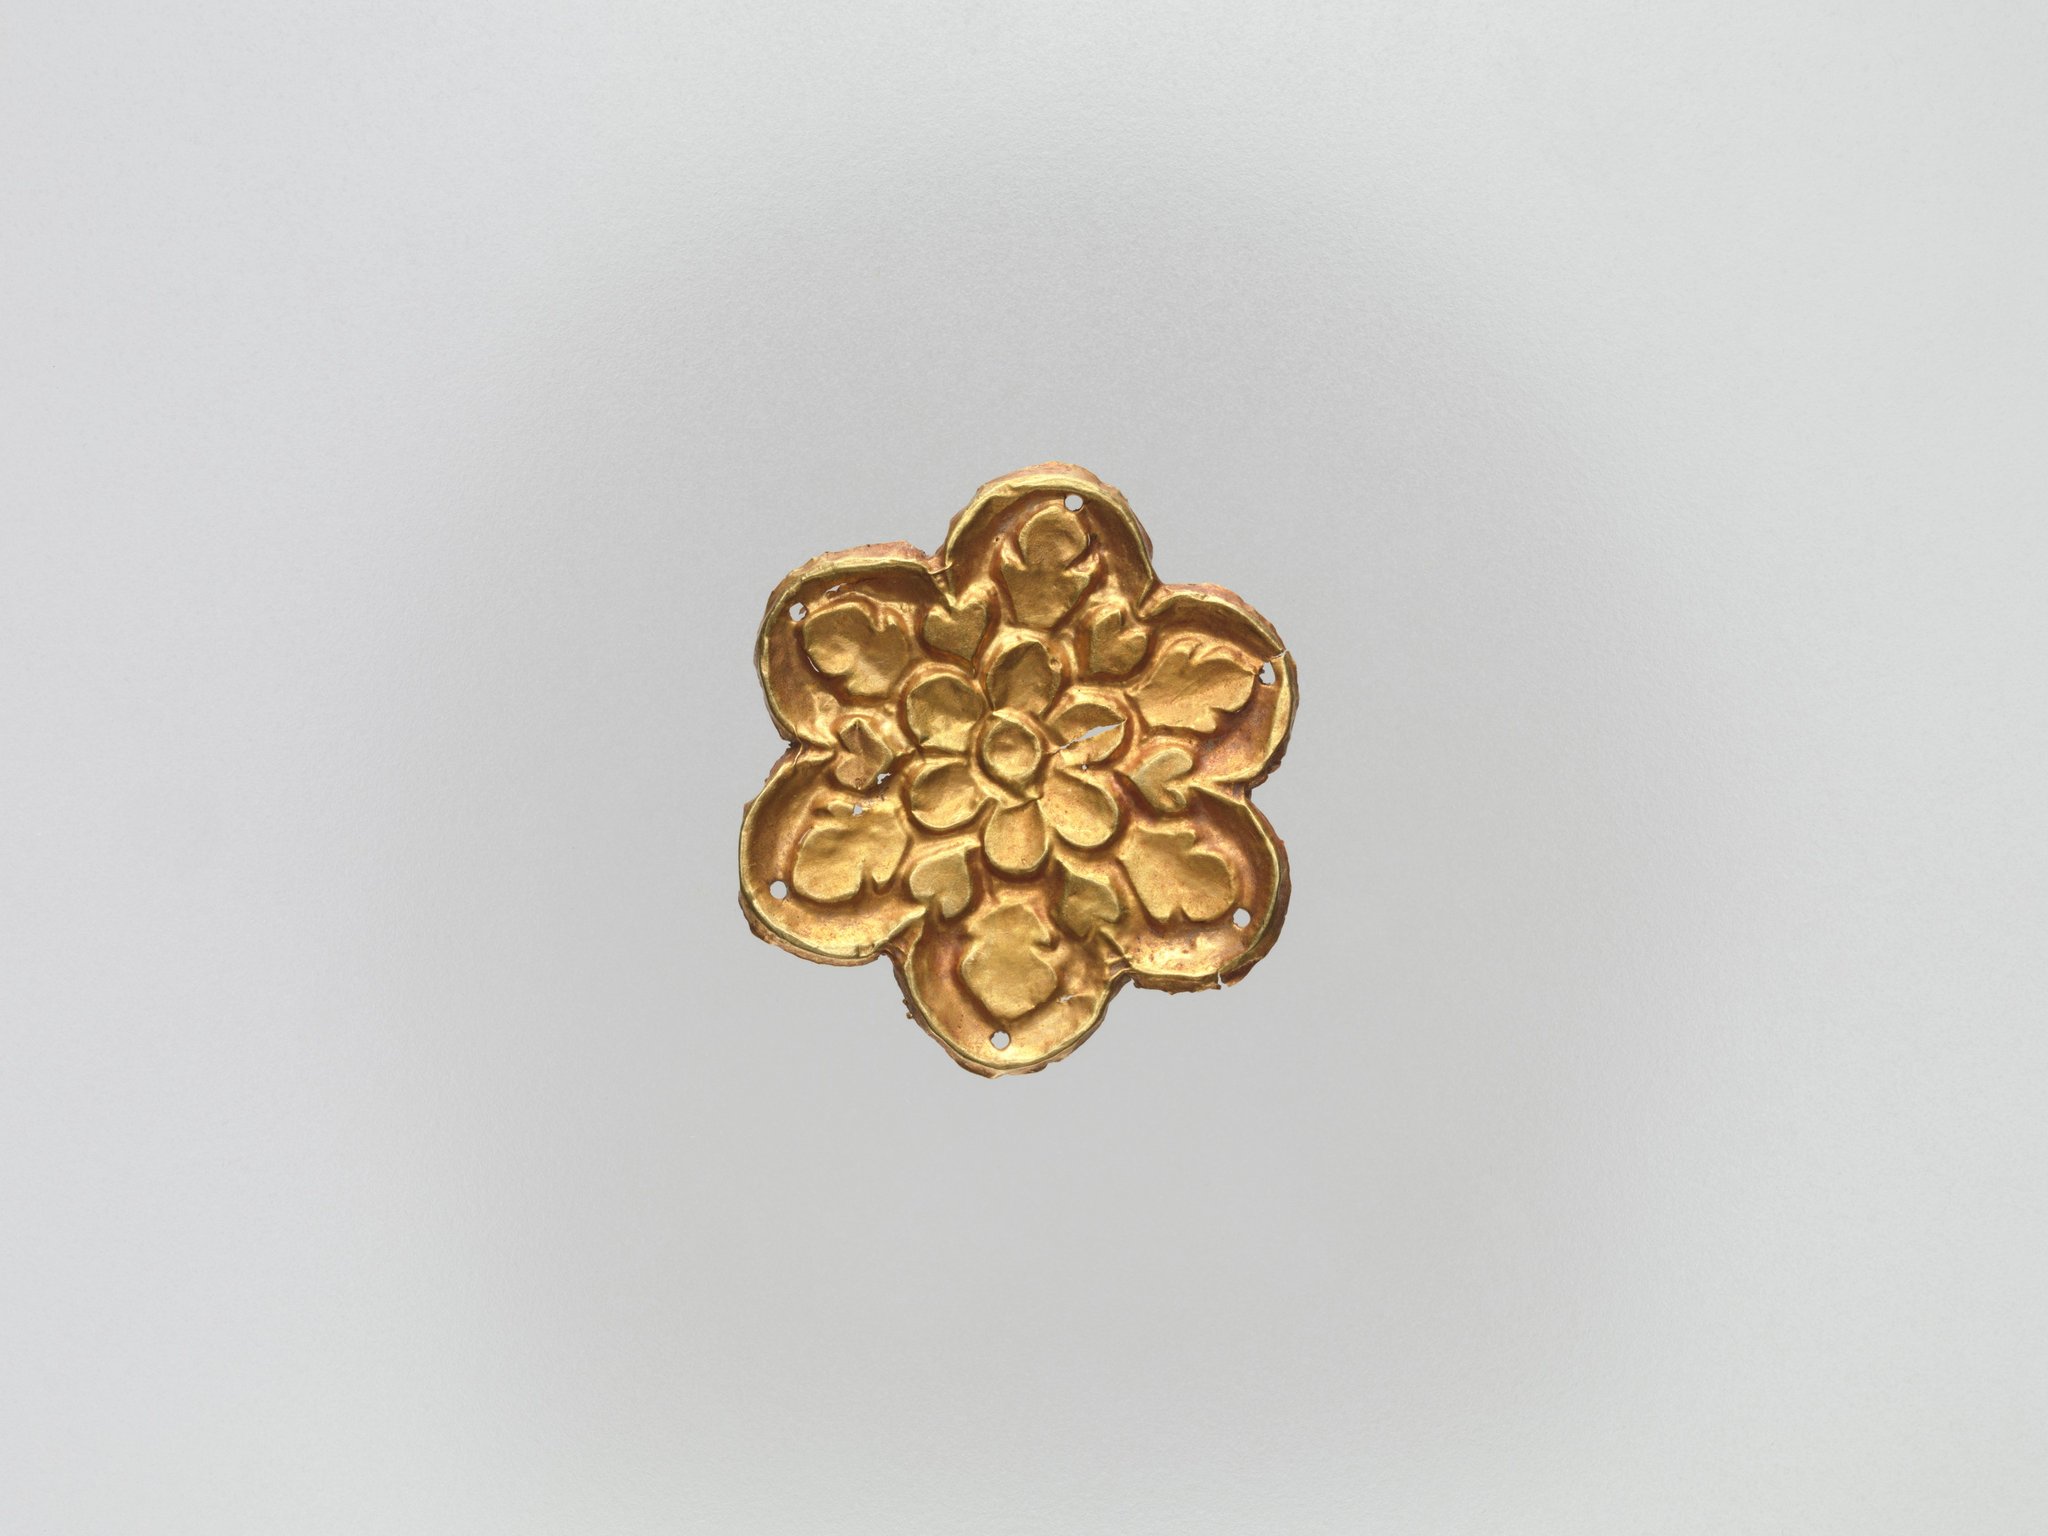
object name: garment plaque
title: Flower-Shaped Clothing Plaque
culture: chinese or central asian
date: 601-900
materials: gold